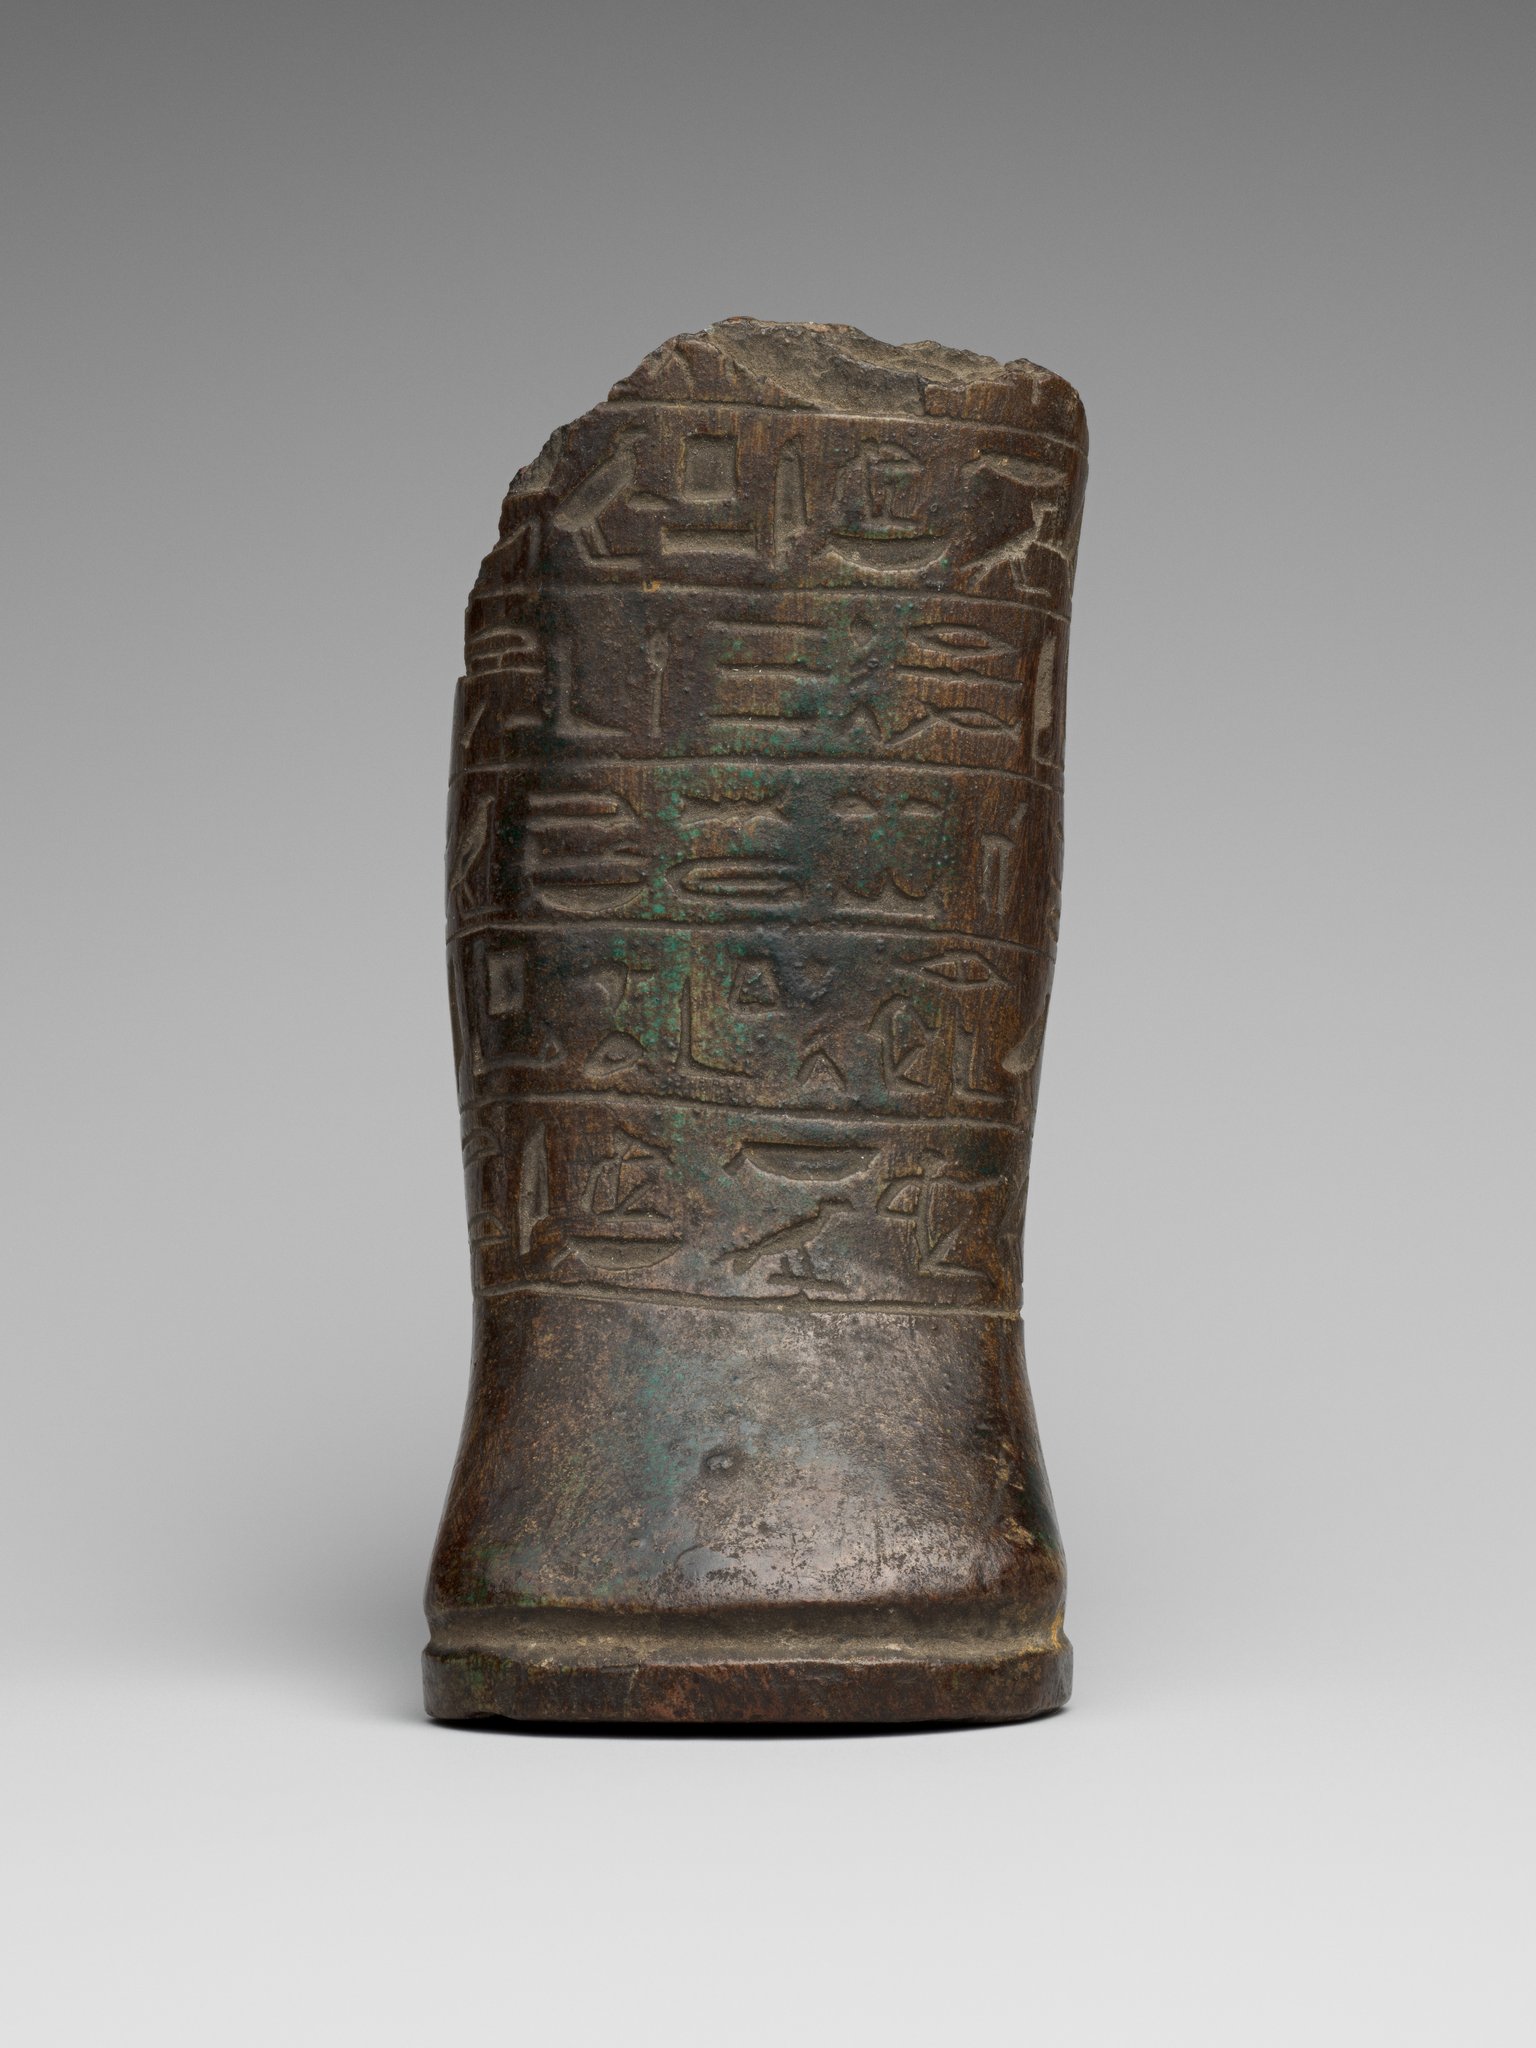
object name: shabti fragment, petamenophis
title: Shabti fragment of Petamenophis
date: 710-640 BCE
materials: stone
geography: egypt